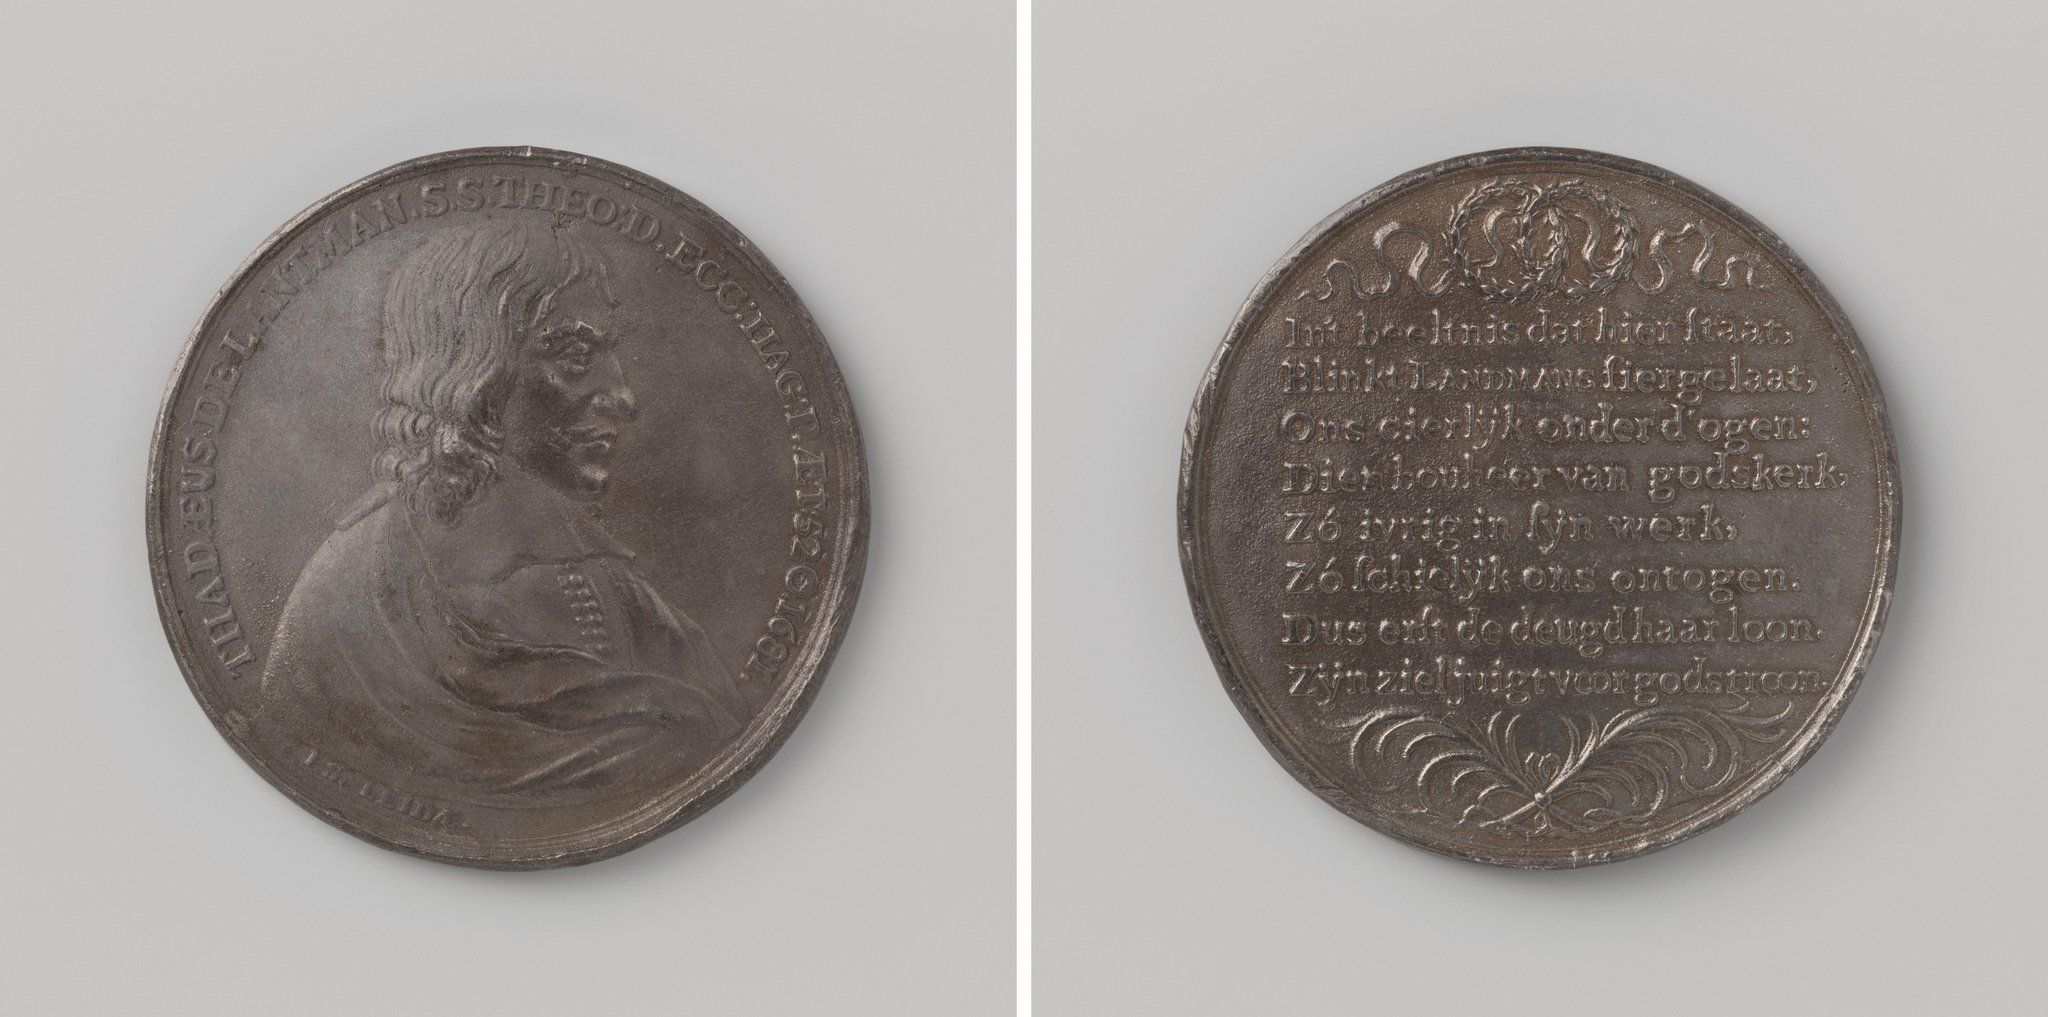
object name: copy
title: Overlijden van Thadaeus de Lantman, predikant te Zevenhoven, Delft, 's- Gravenhage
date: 1681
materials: metal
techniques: striking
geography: leiden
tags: the hague, delft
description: Voorzijde: borststuk man binnen omschrift. Keerzijde: twee ineen gevlochten lauwerkransen met lint boven opschrift. Vermoedelijk een kopie.